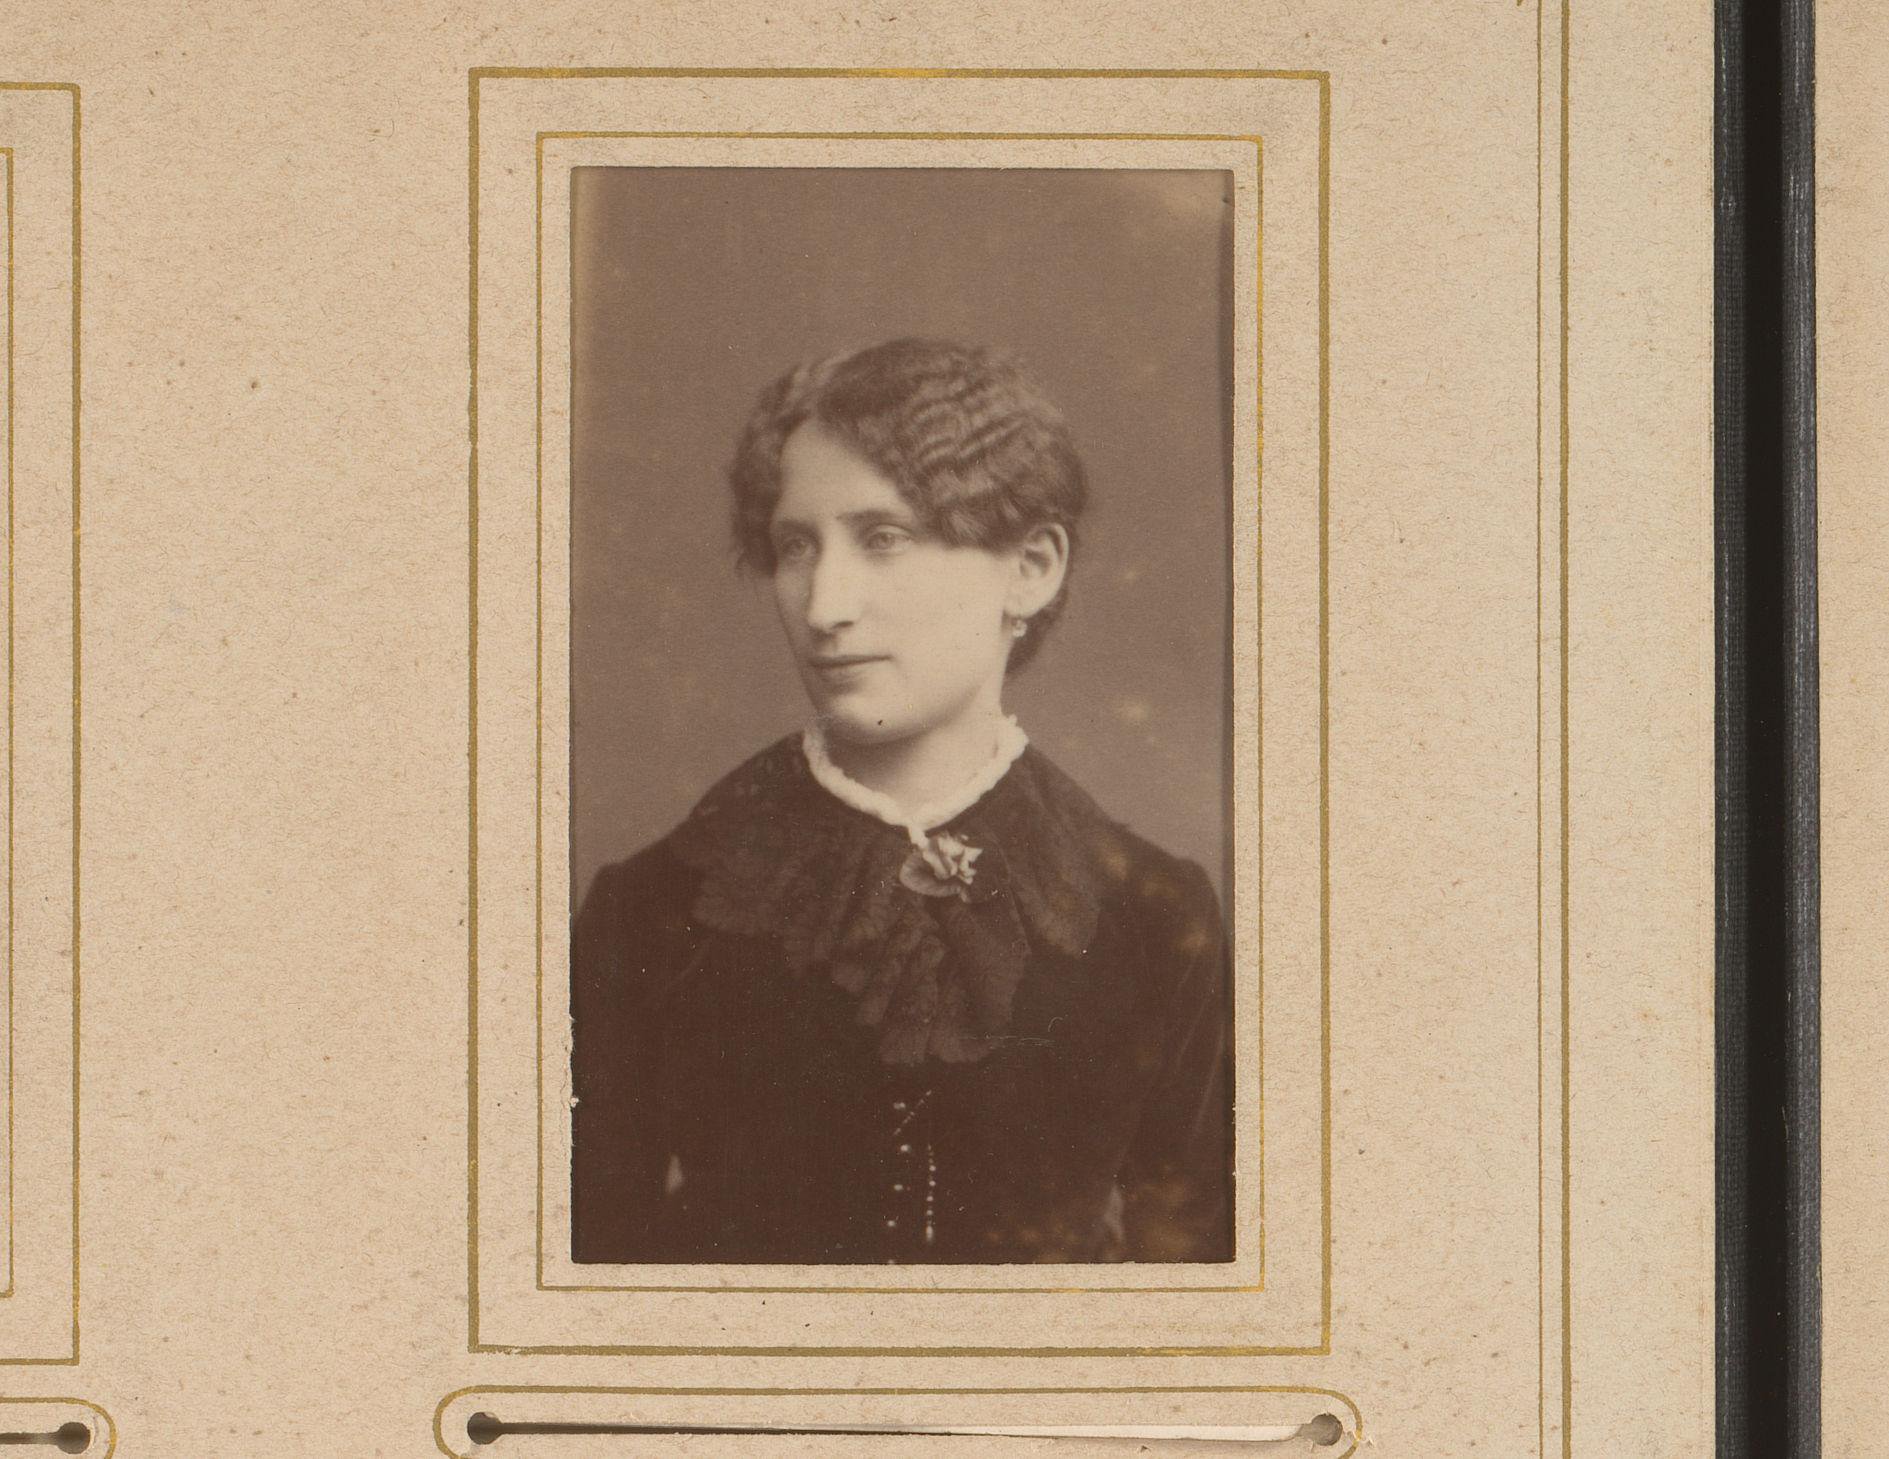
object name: album leaf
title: Portret van een vrouw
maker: j. van crewel jeune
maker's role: fotograaf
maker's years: 1852-1930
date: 1883-1905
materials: cardboard, photographic support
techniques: albumen print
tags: adult woman, historical persons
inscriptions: name: ‘J. van Crewel Jne Phot. Anvers’, inscription: ‘Brevet D'invention/ médaille d'argenta/ l'exposition rubens 1881/ (...)’